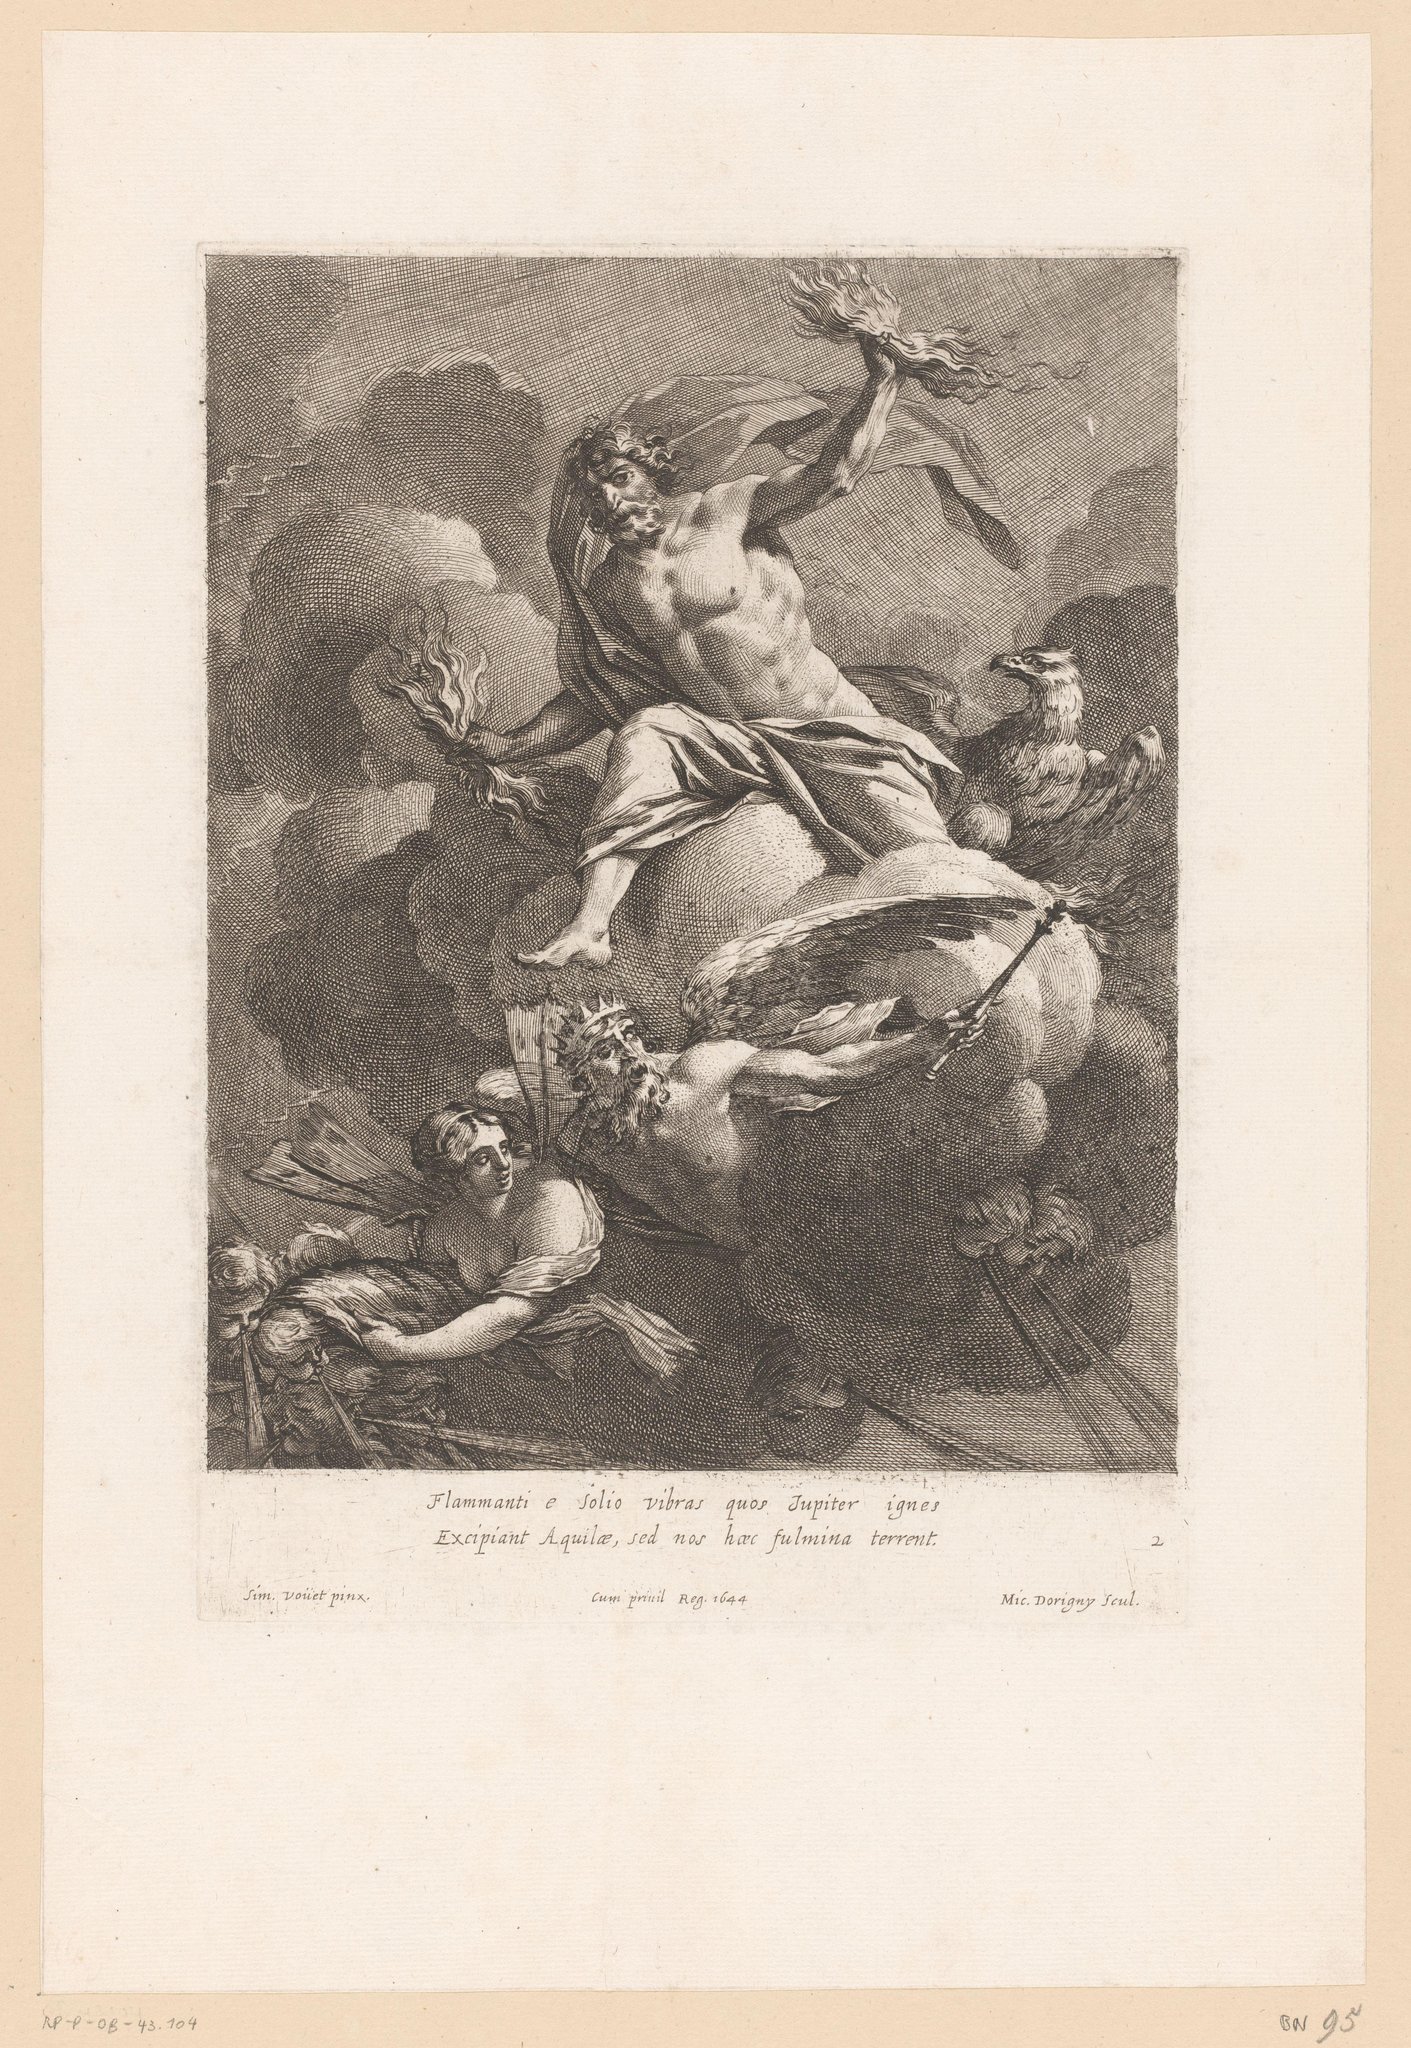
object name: print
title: Serie van prenten naar de schilderijen van Fontainebleau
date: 1644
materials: paper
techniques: engraving, etching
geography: france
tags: (story of) jupiter (zeus), attributes of jupiter: thunderbolt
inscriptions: collector's mark: Lugt 240